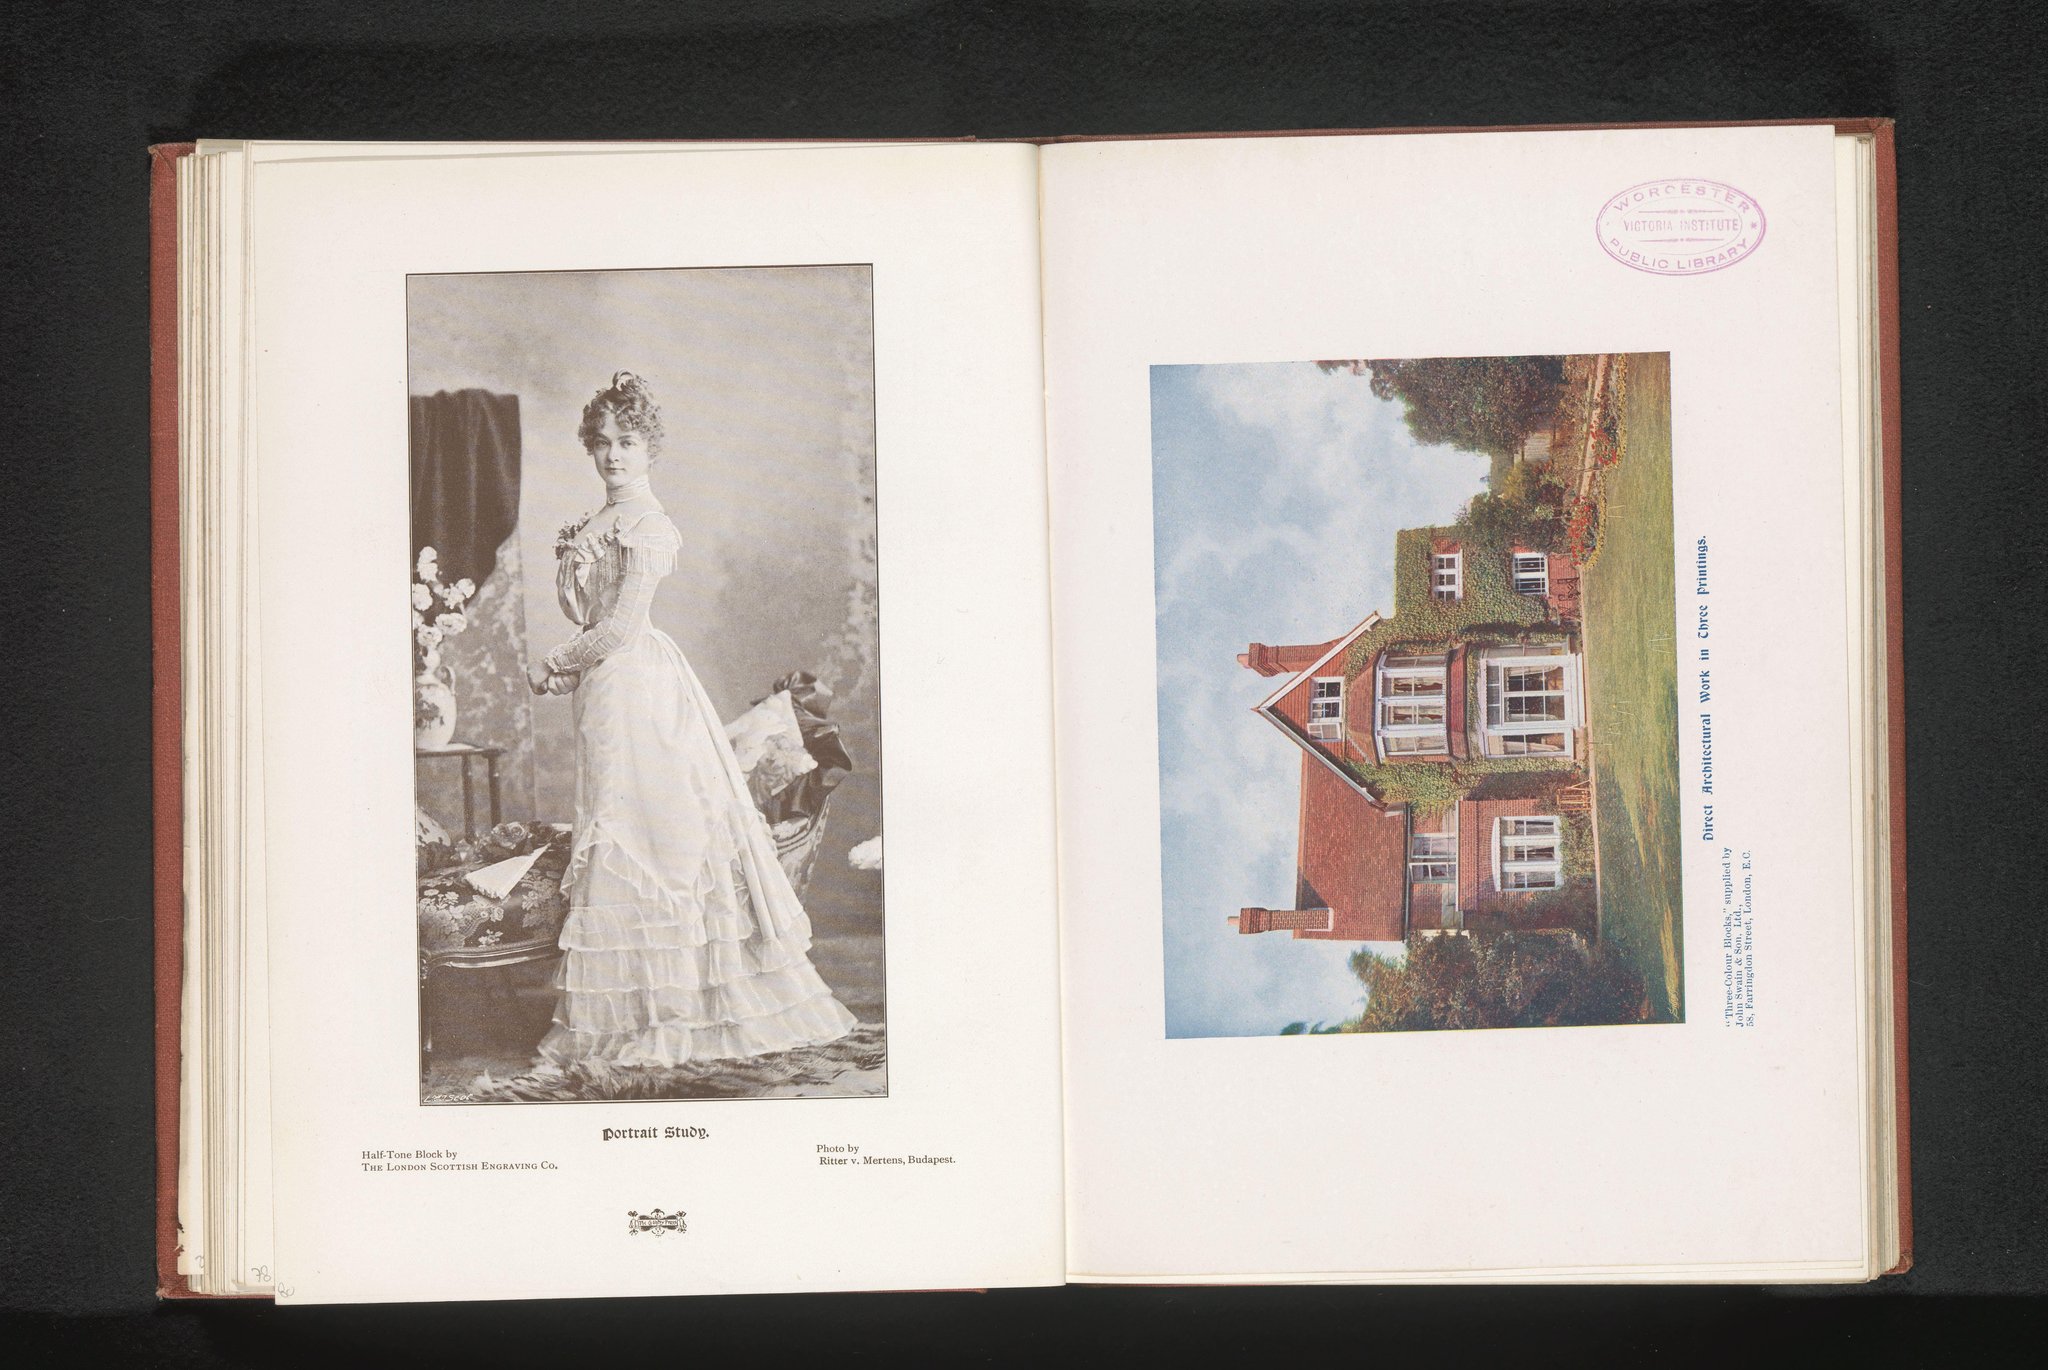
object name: photomechanical print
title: Direct architectural work in three printings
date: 1895-1900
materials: paper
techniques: three-color autotype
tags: villa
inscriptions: collector's mark: ‘Worcester Public Library/ Victoria Institute’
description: Prent op vijfde ongenummerde pagina na pagina 64.